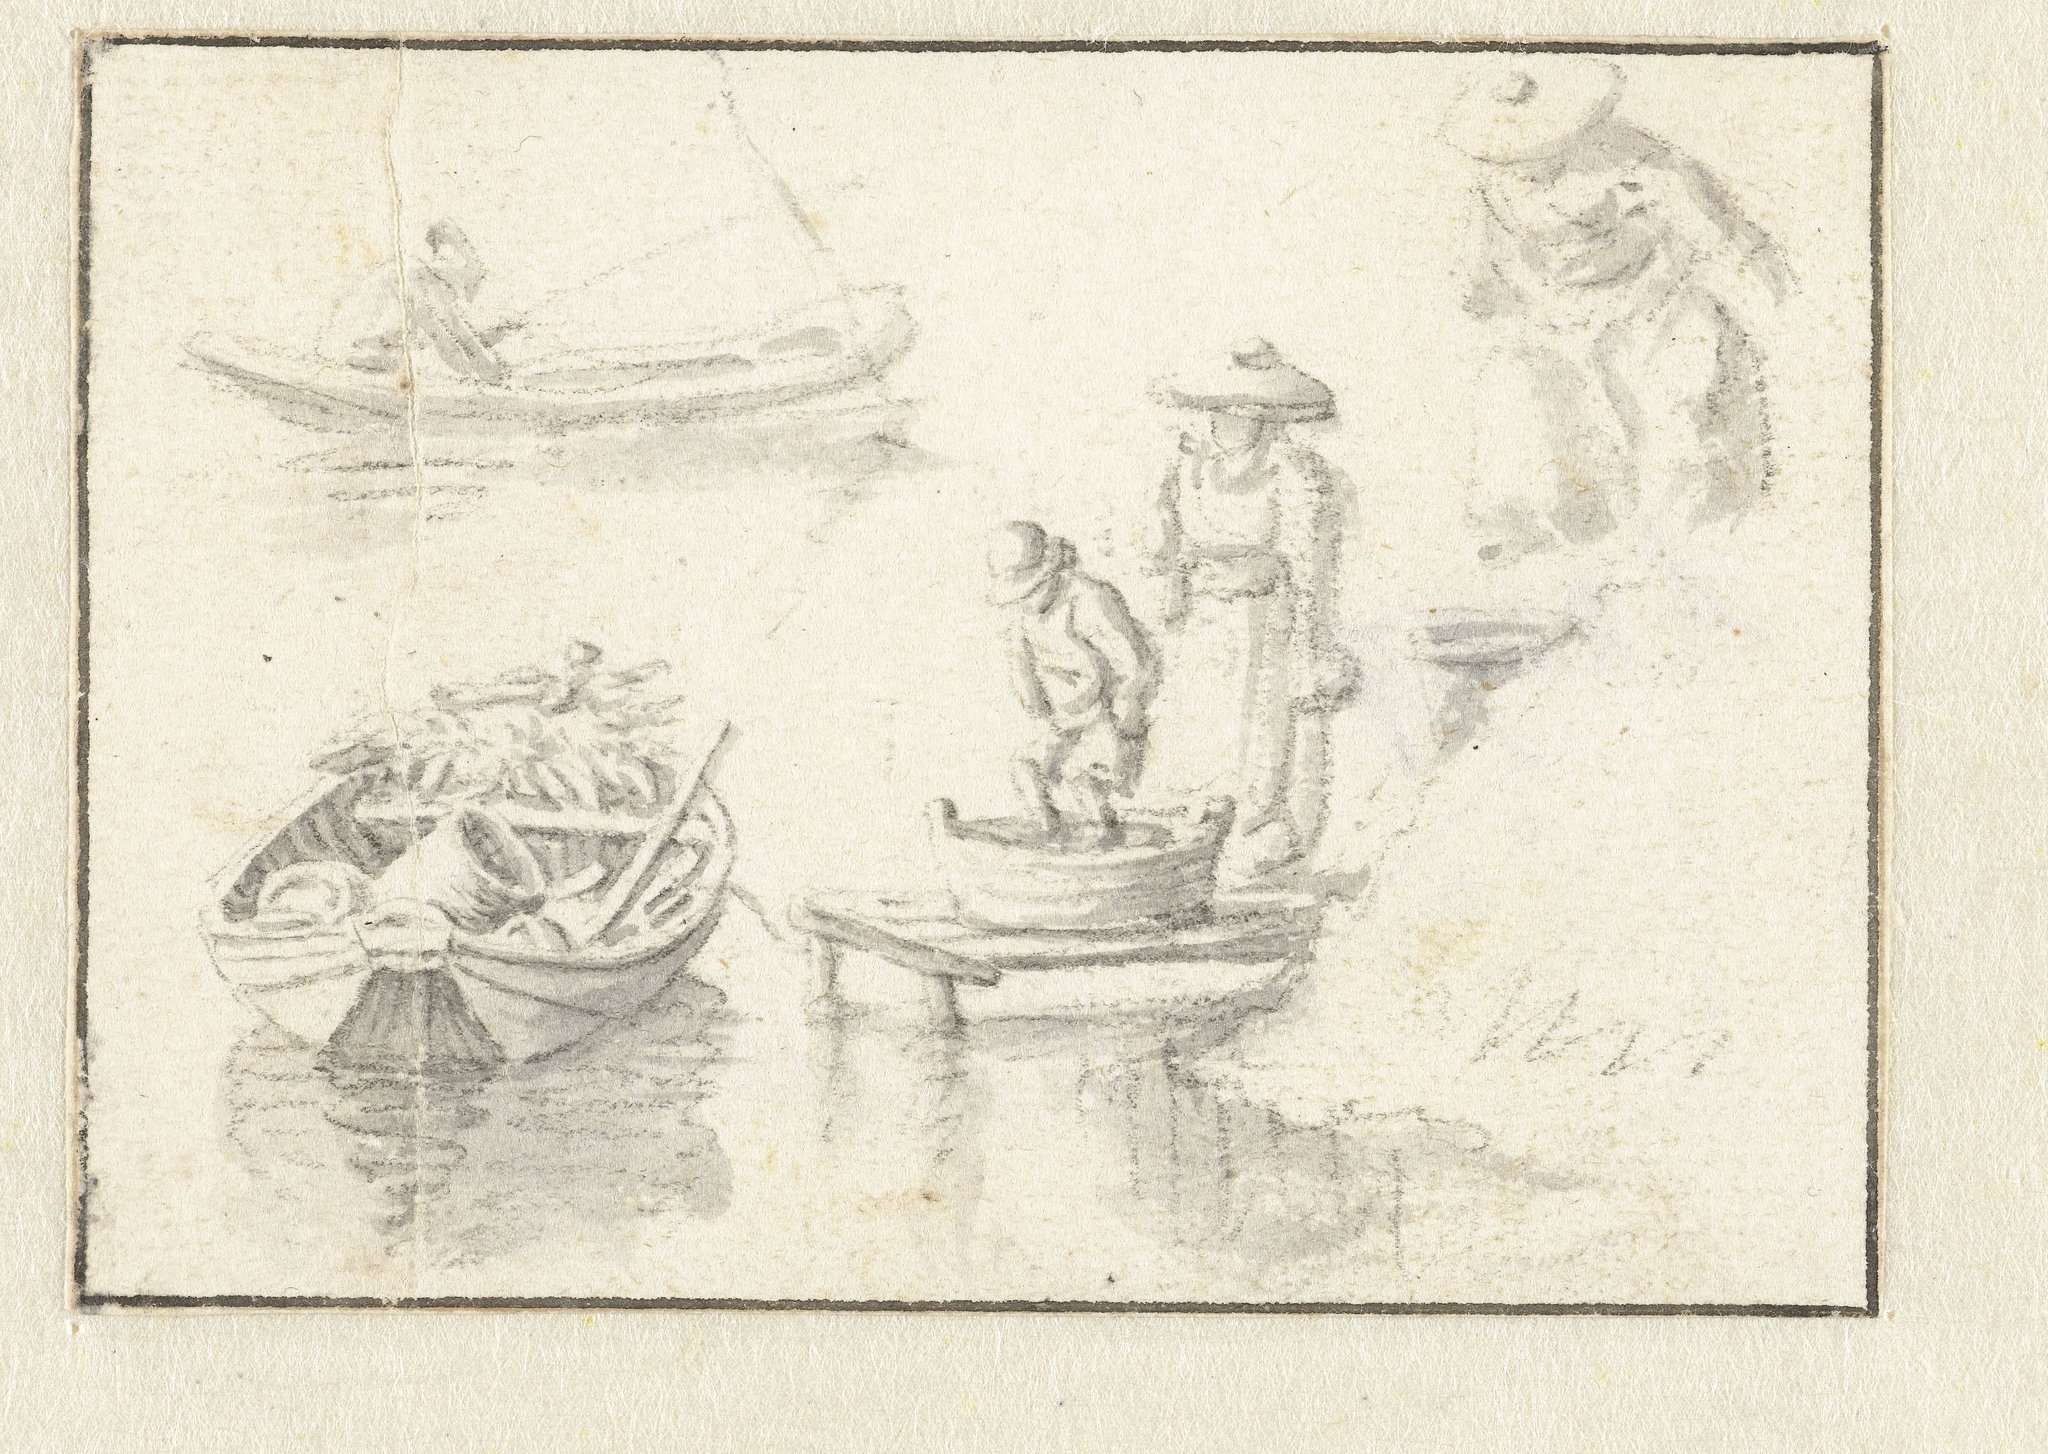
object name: drawing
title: Bootje bij een steiger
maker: herman saftleven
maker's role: draughtsman, painter, print maker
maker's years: 1609-1685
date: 1619-1685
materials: chalk, paper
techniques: brush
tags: rowing-boat, canoe, etc.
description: Bootje bij een steiger, met daarop drie personen.